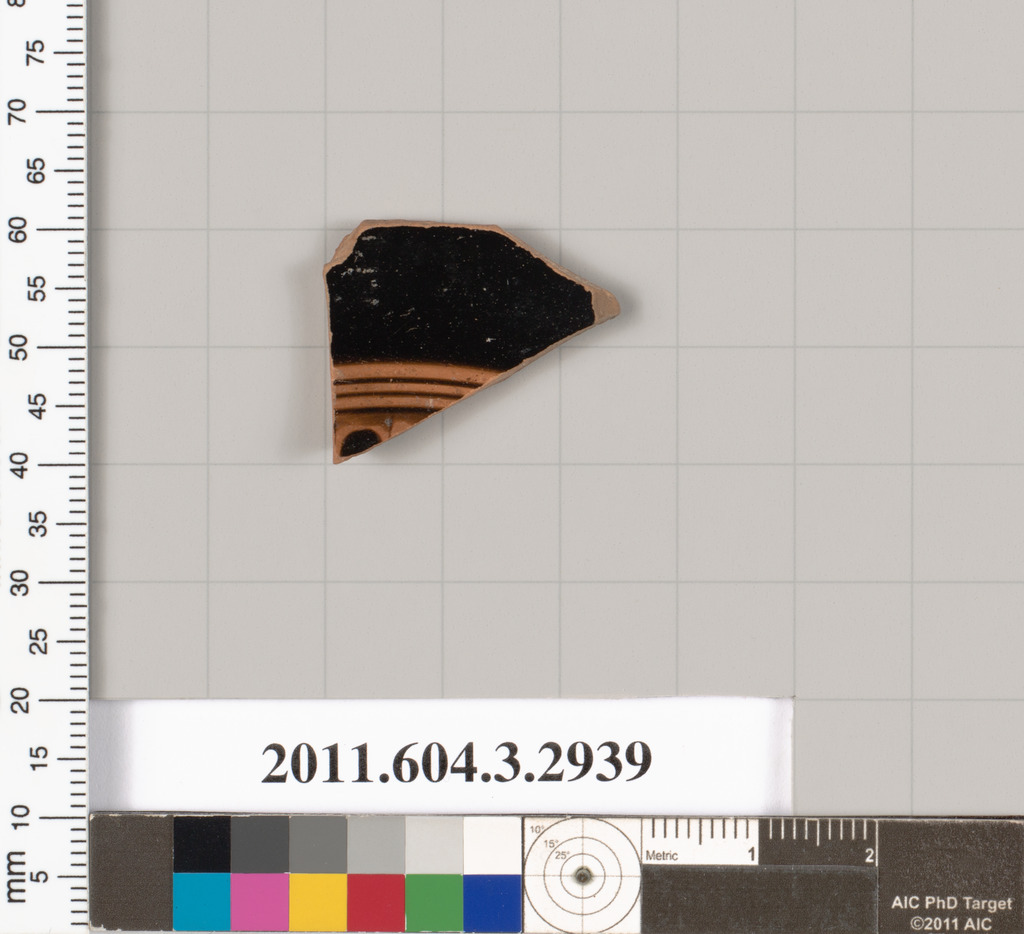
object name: kylix fragment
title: Terracotta fragment of a kylix (drinking cup)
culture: greek, attic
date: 567-535 BCE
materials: terracotta